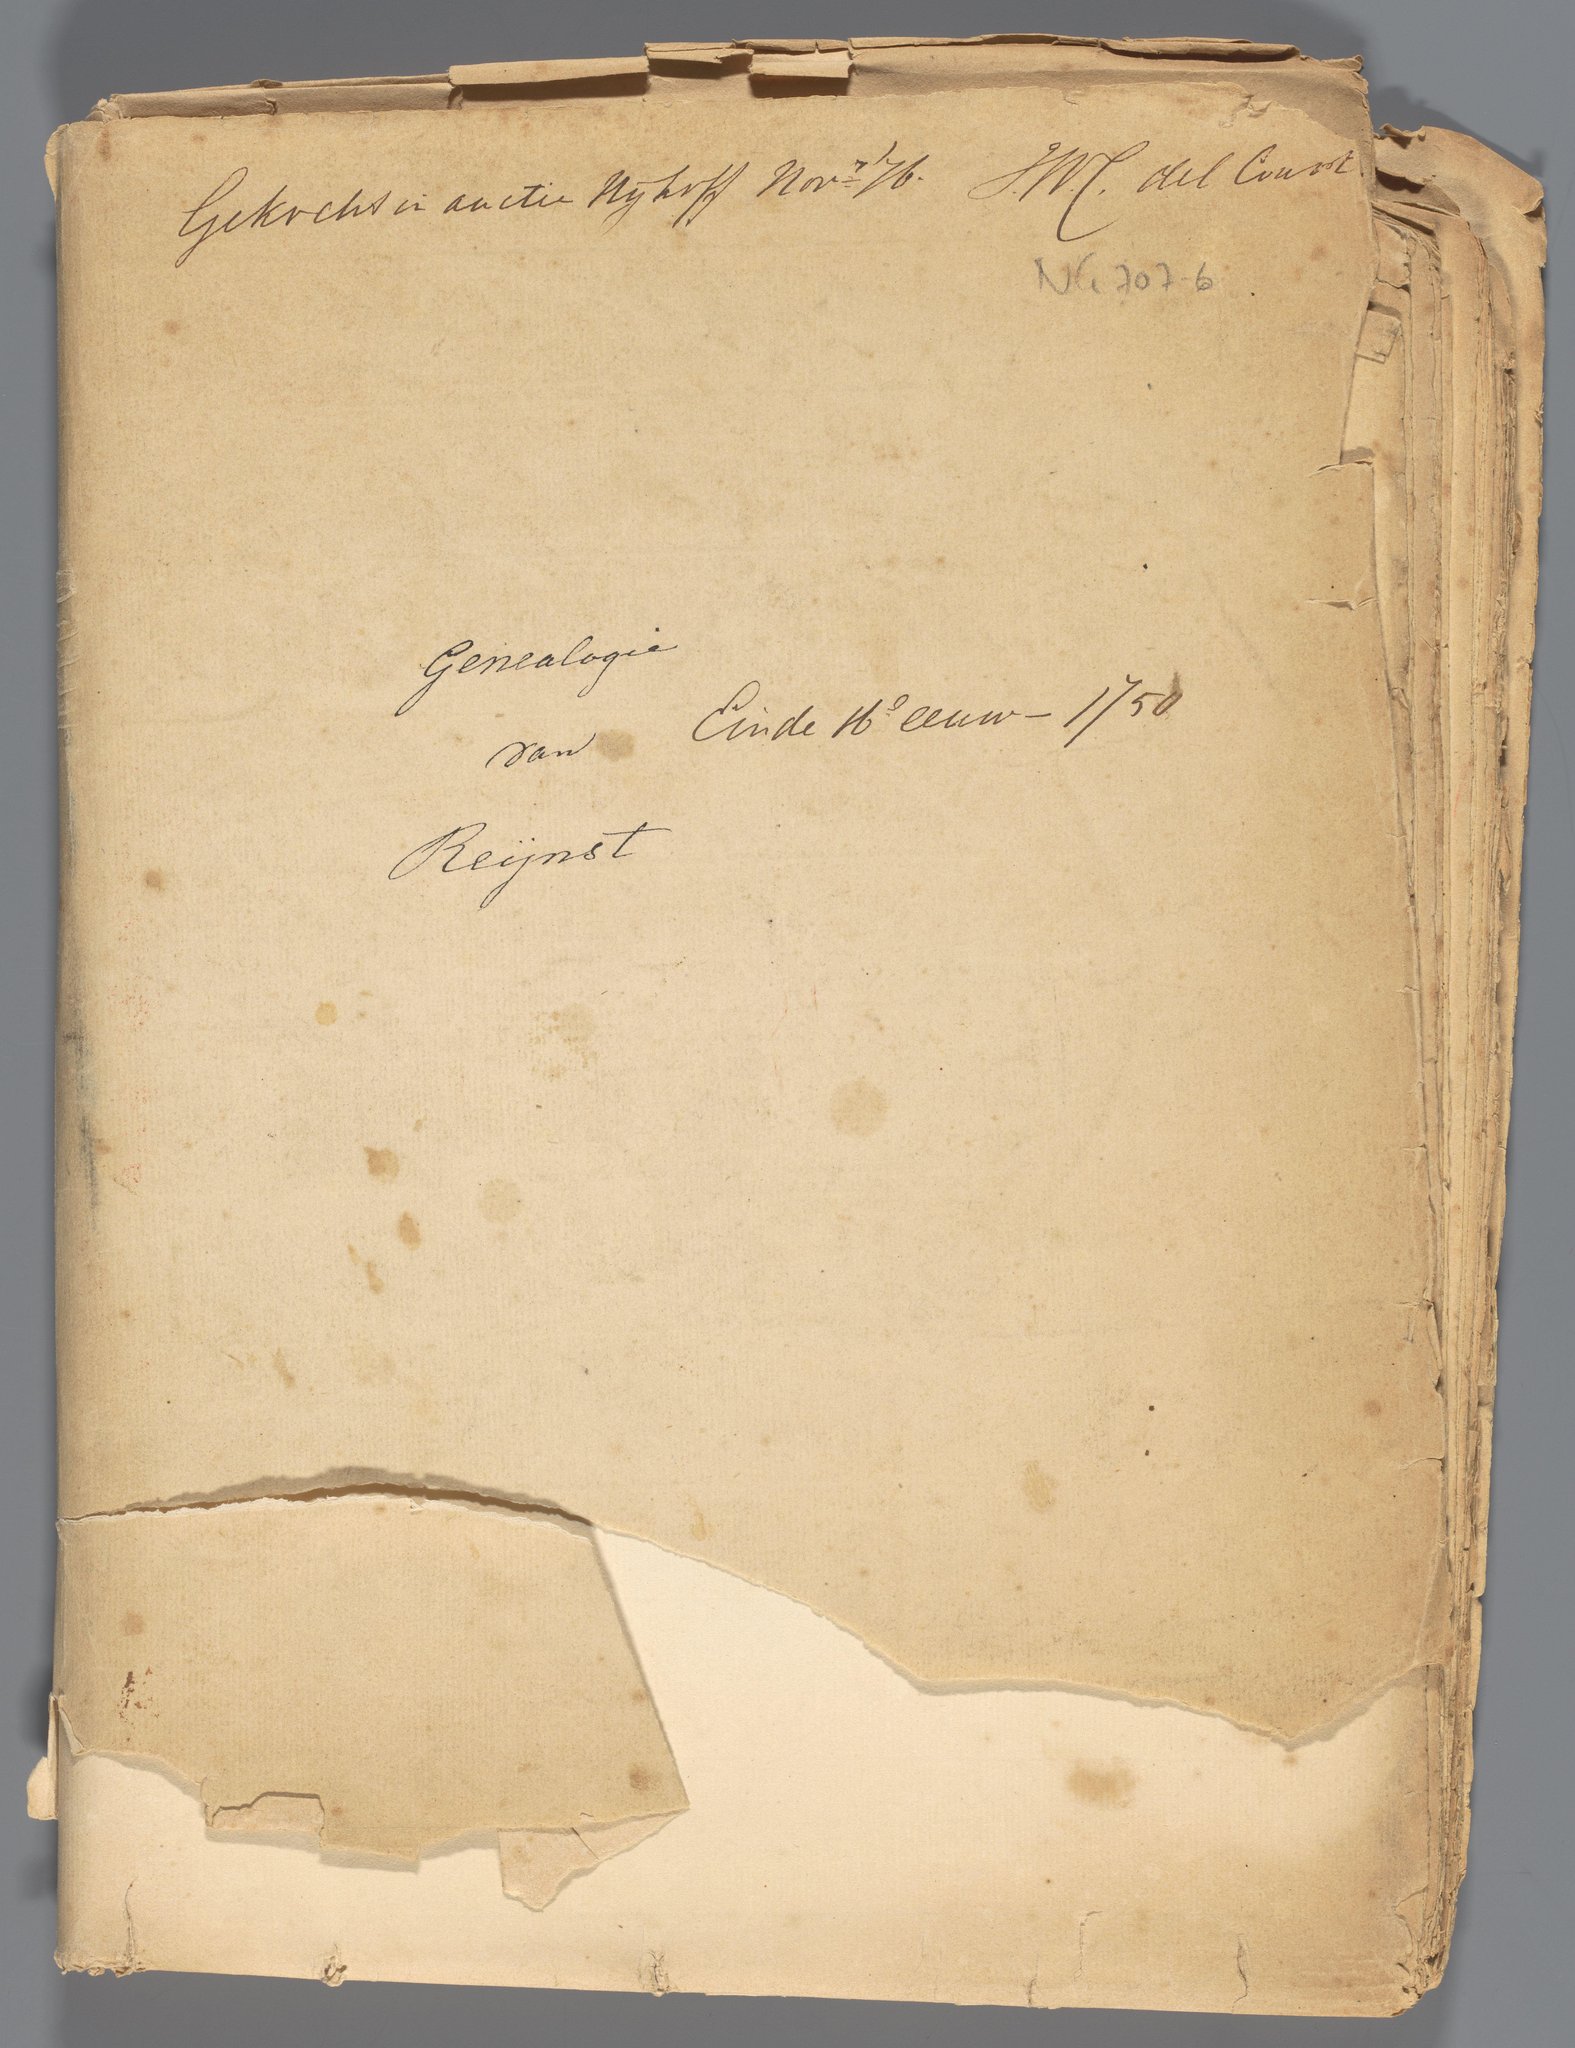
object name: manuscript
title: Généalogie van Reynst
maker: j.w.c. del court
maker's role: schrijver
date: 1876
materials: ink, paper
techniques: writing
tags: reynst, familie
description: Handgeschreven genealogie van het geslacht Reijnst, 10 beschreven pp, rest leeg. Opschrift: 'Auctie Nijhoff 1876 J.W.C. del Court'.